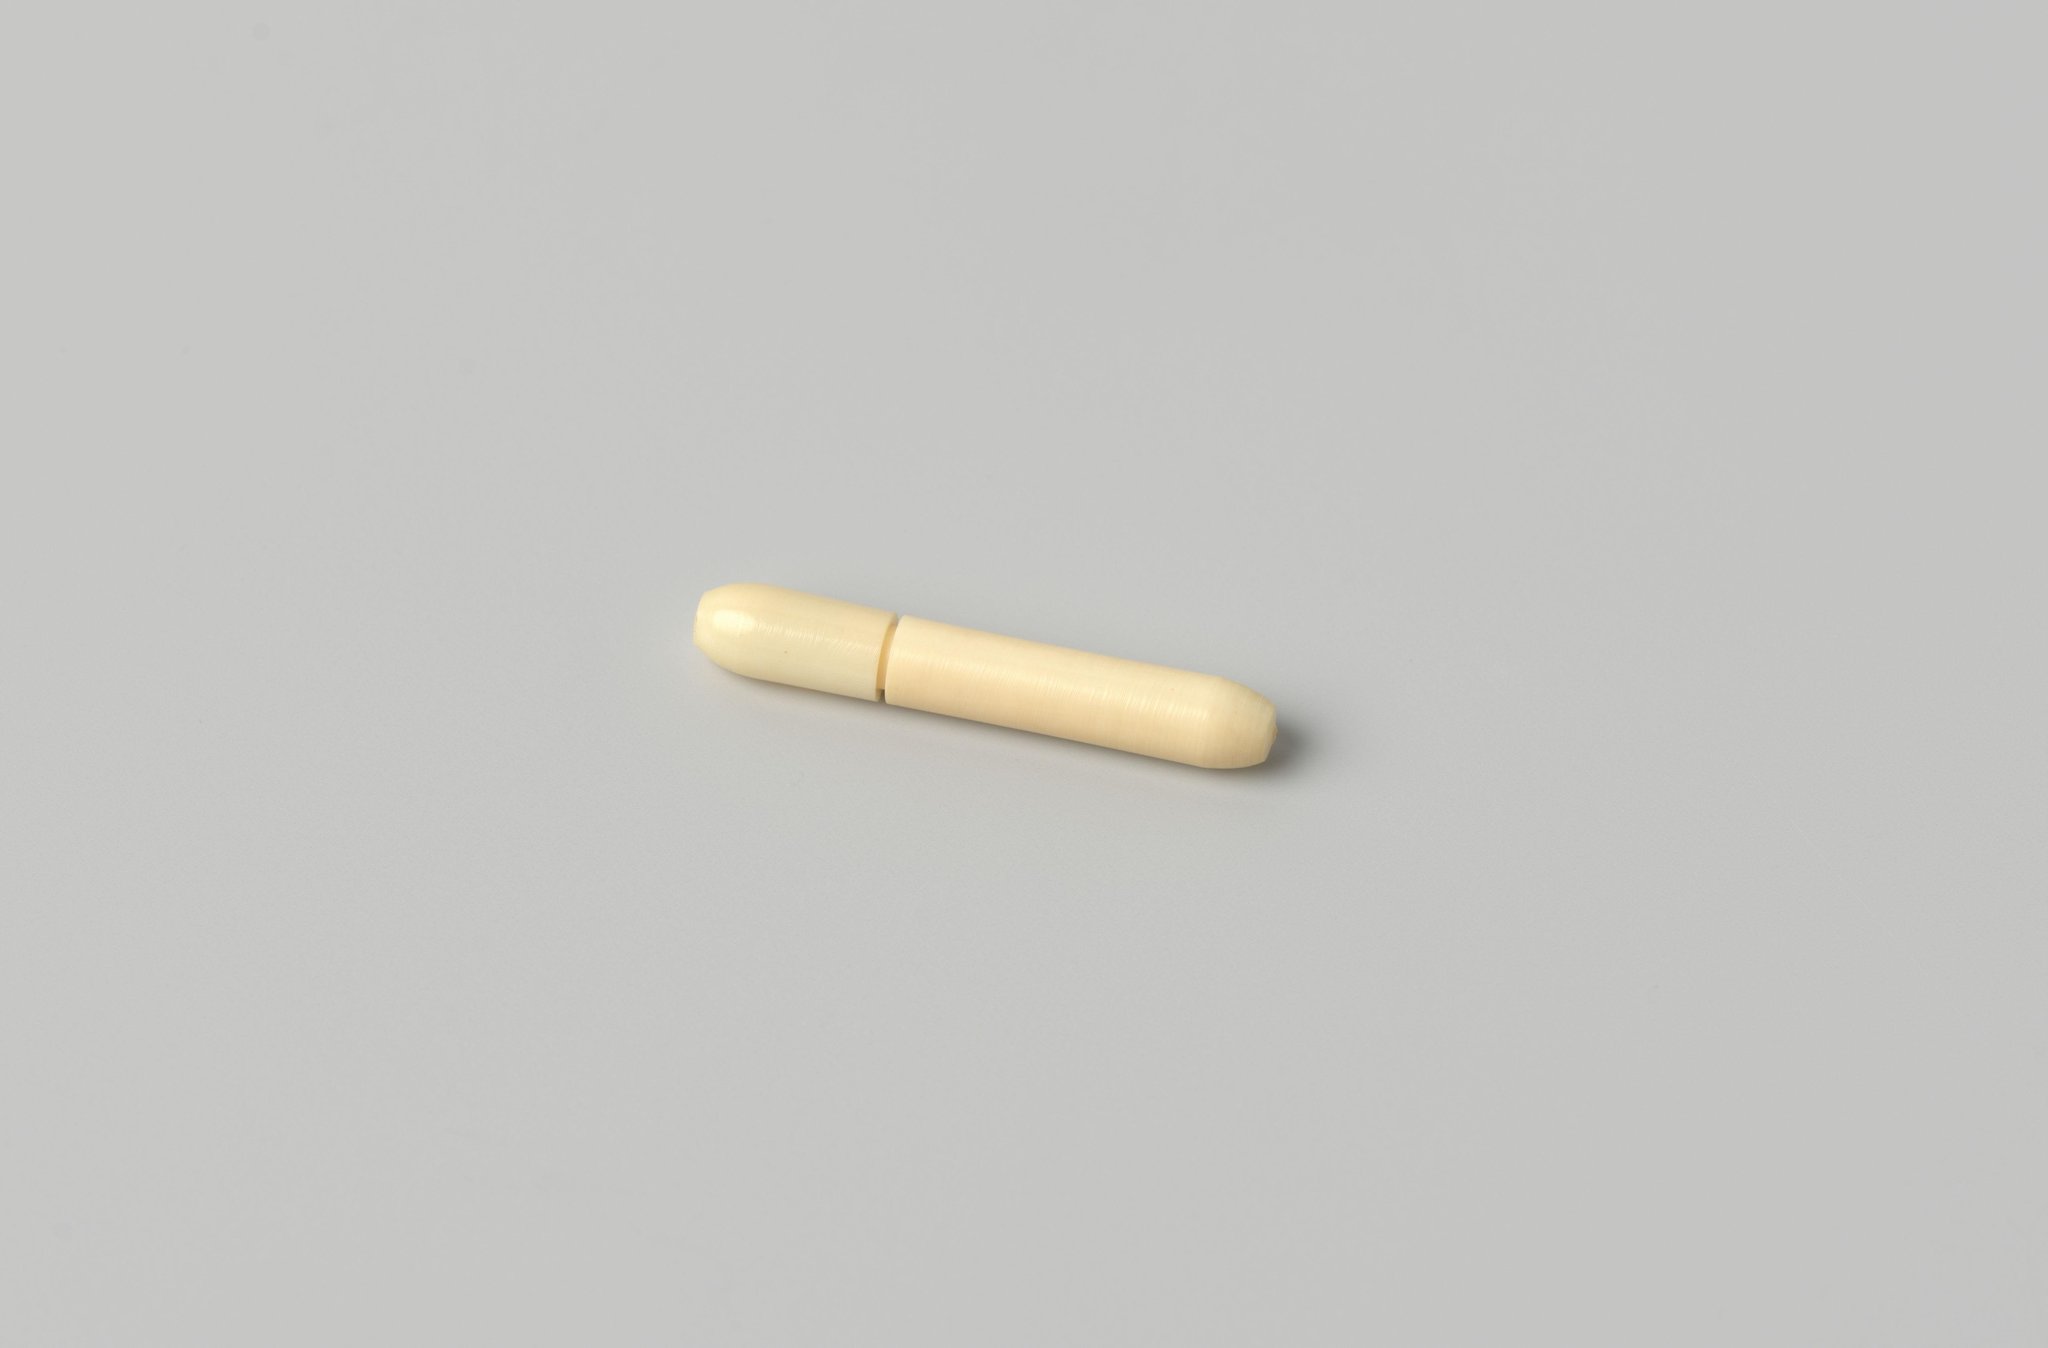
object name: poppengoed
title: Naaldenkoker van ivoor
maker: Anonymous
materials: ivory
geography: netherlands